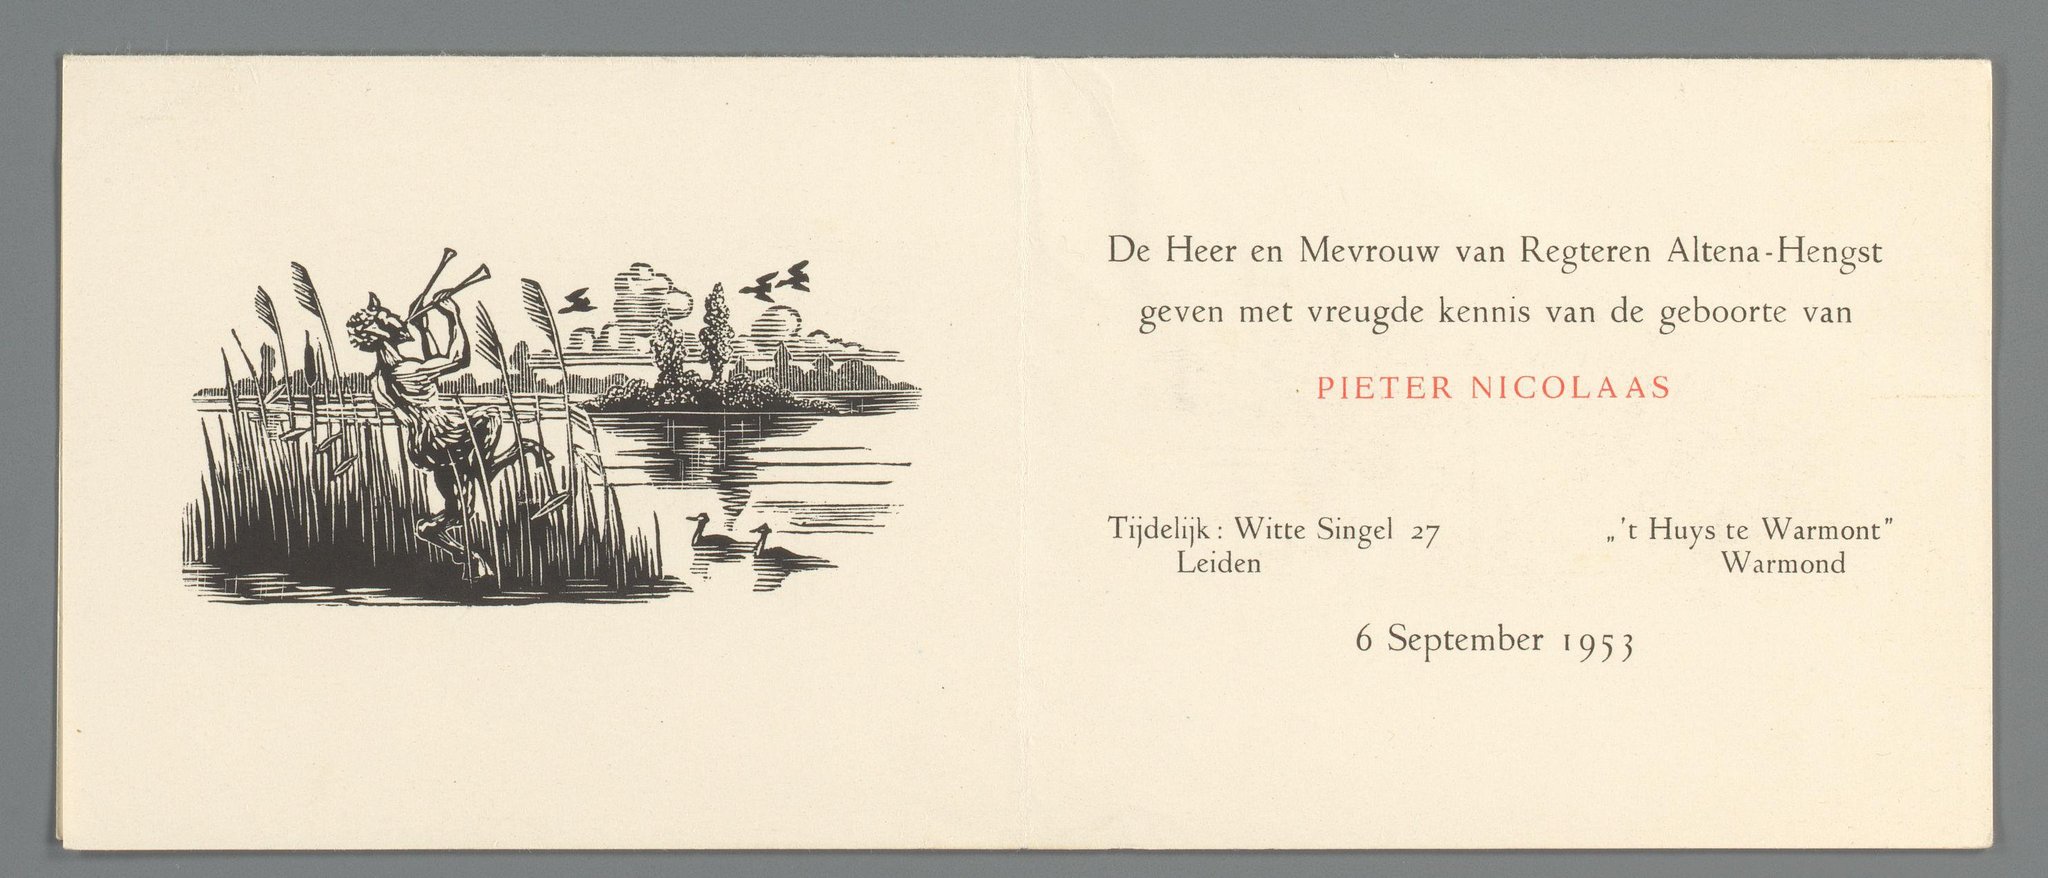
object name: birth announcement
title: Geboortekaart voor Pieter Nicolaas van Regteren Altena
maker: Anonymous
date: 1953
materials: paper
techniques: printing block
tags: satyr(s) (in general), announcement of birth, flute, aulos, tibia - cc - out of doors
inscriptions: annotation: ‘fa. Herzberger T. 2341017.’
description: Links een fluitspelende sater in een drassig gebied. Rechts de tekst: 'De Heer en Mevrouw van Regteren Altena-Hengst geven met vreugde kennis van de geboorte van Pieter Nicolaas. Tijdelijk: Witte Singel 27 Leiden. "'t Huys te Warmont" Warmond. 6 September 1953'.